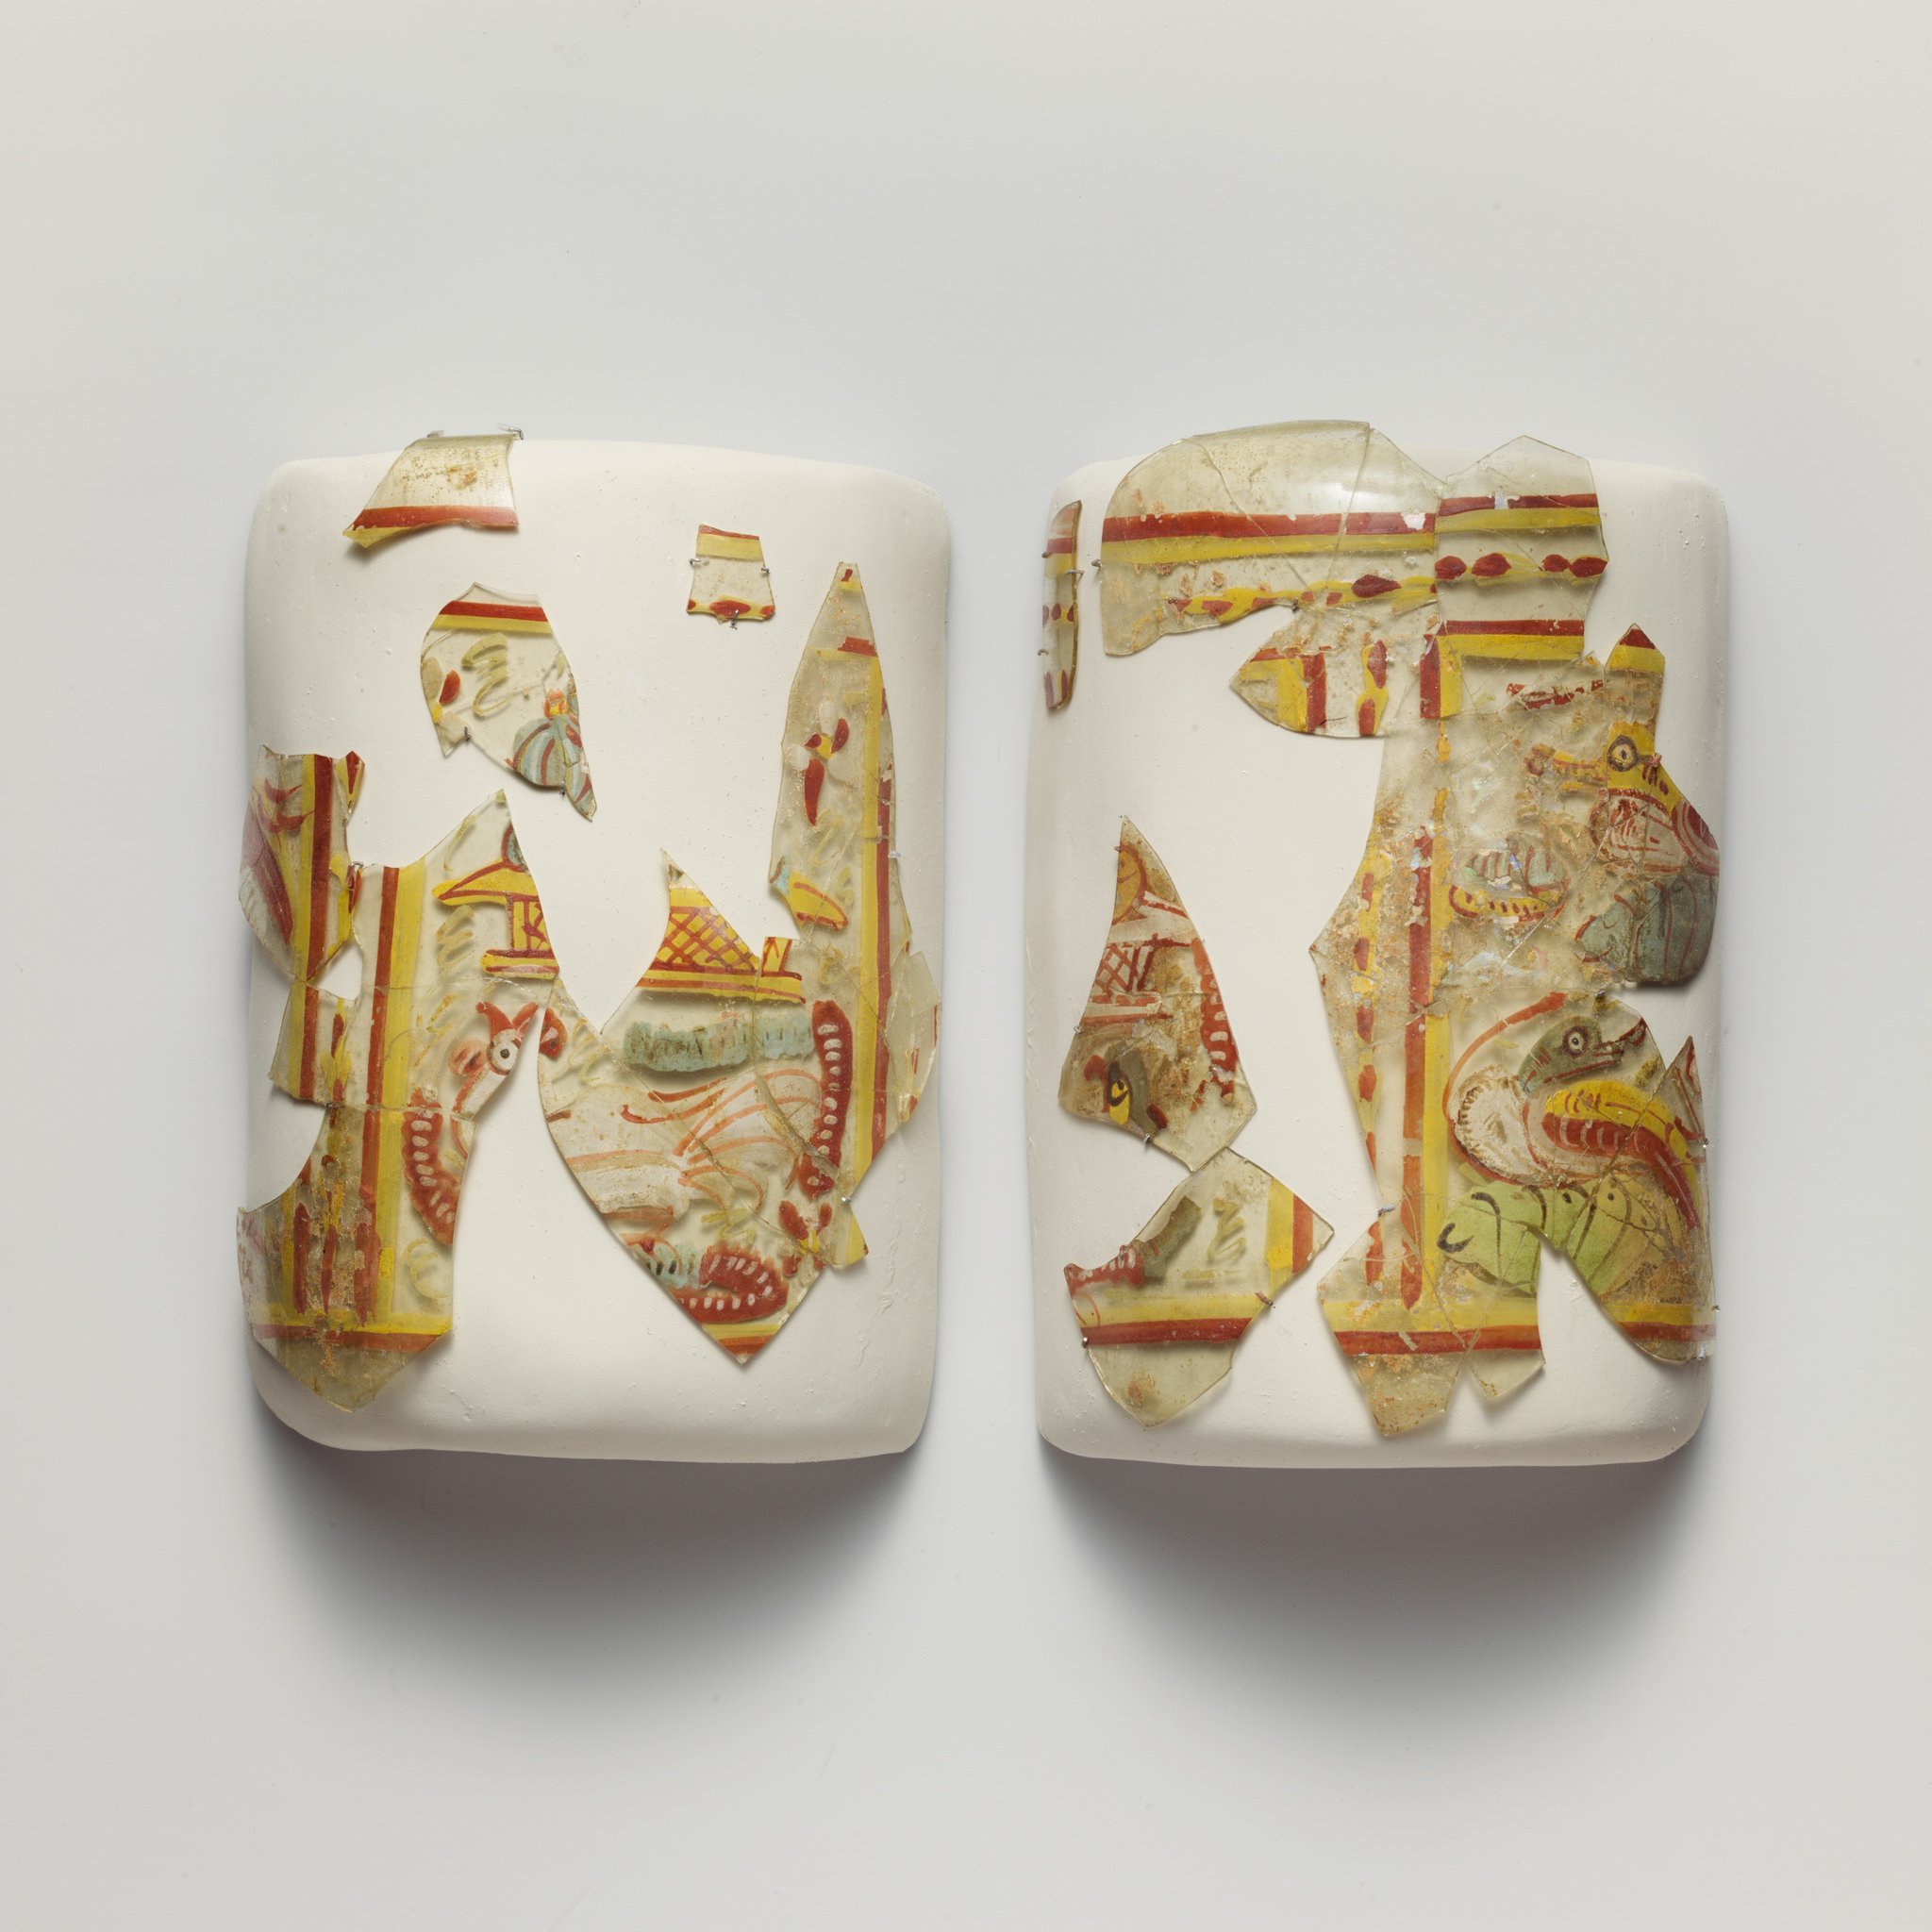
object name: bottle fragment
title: Glass cylindrical bottle with painted decoration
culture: roman, egyptian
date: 101-200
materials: glass